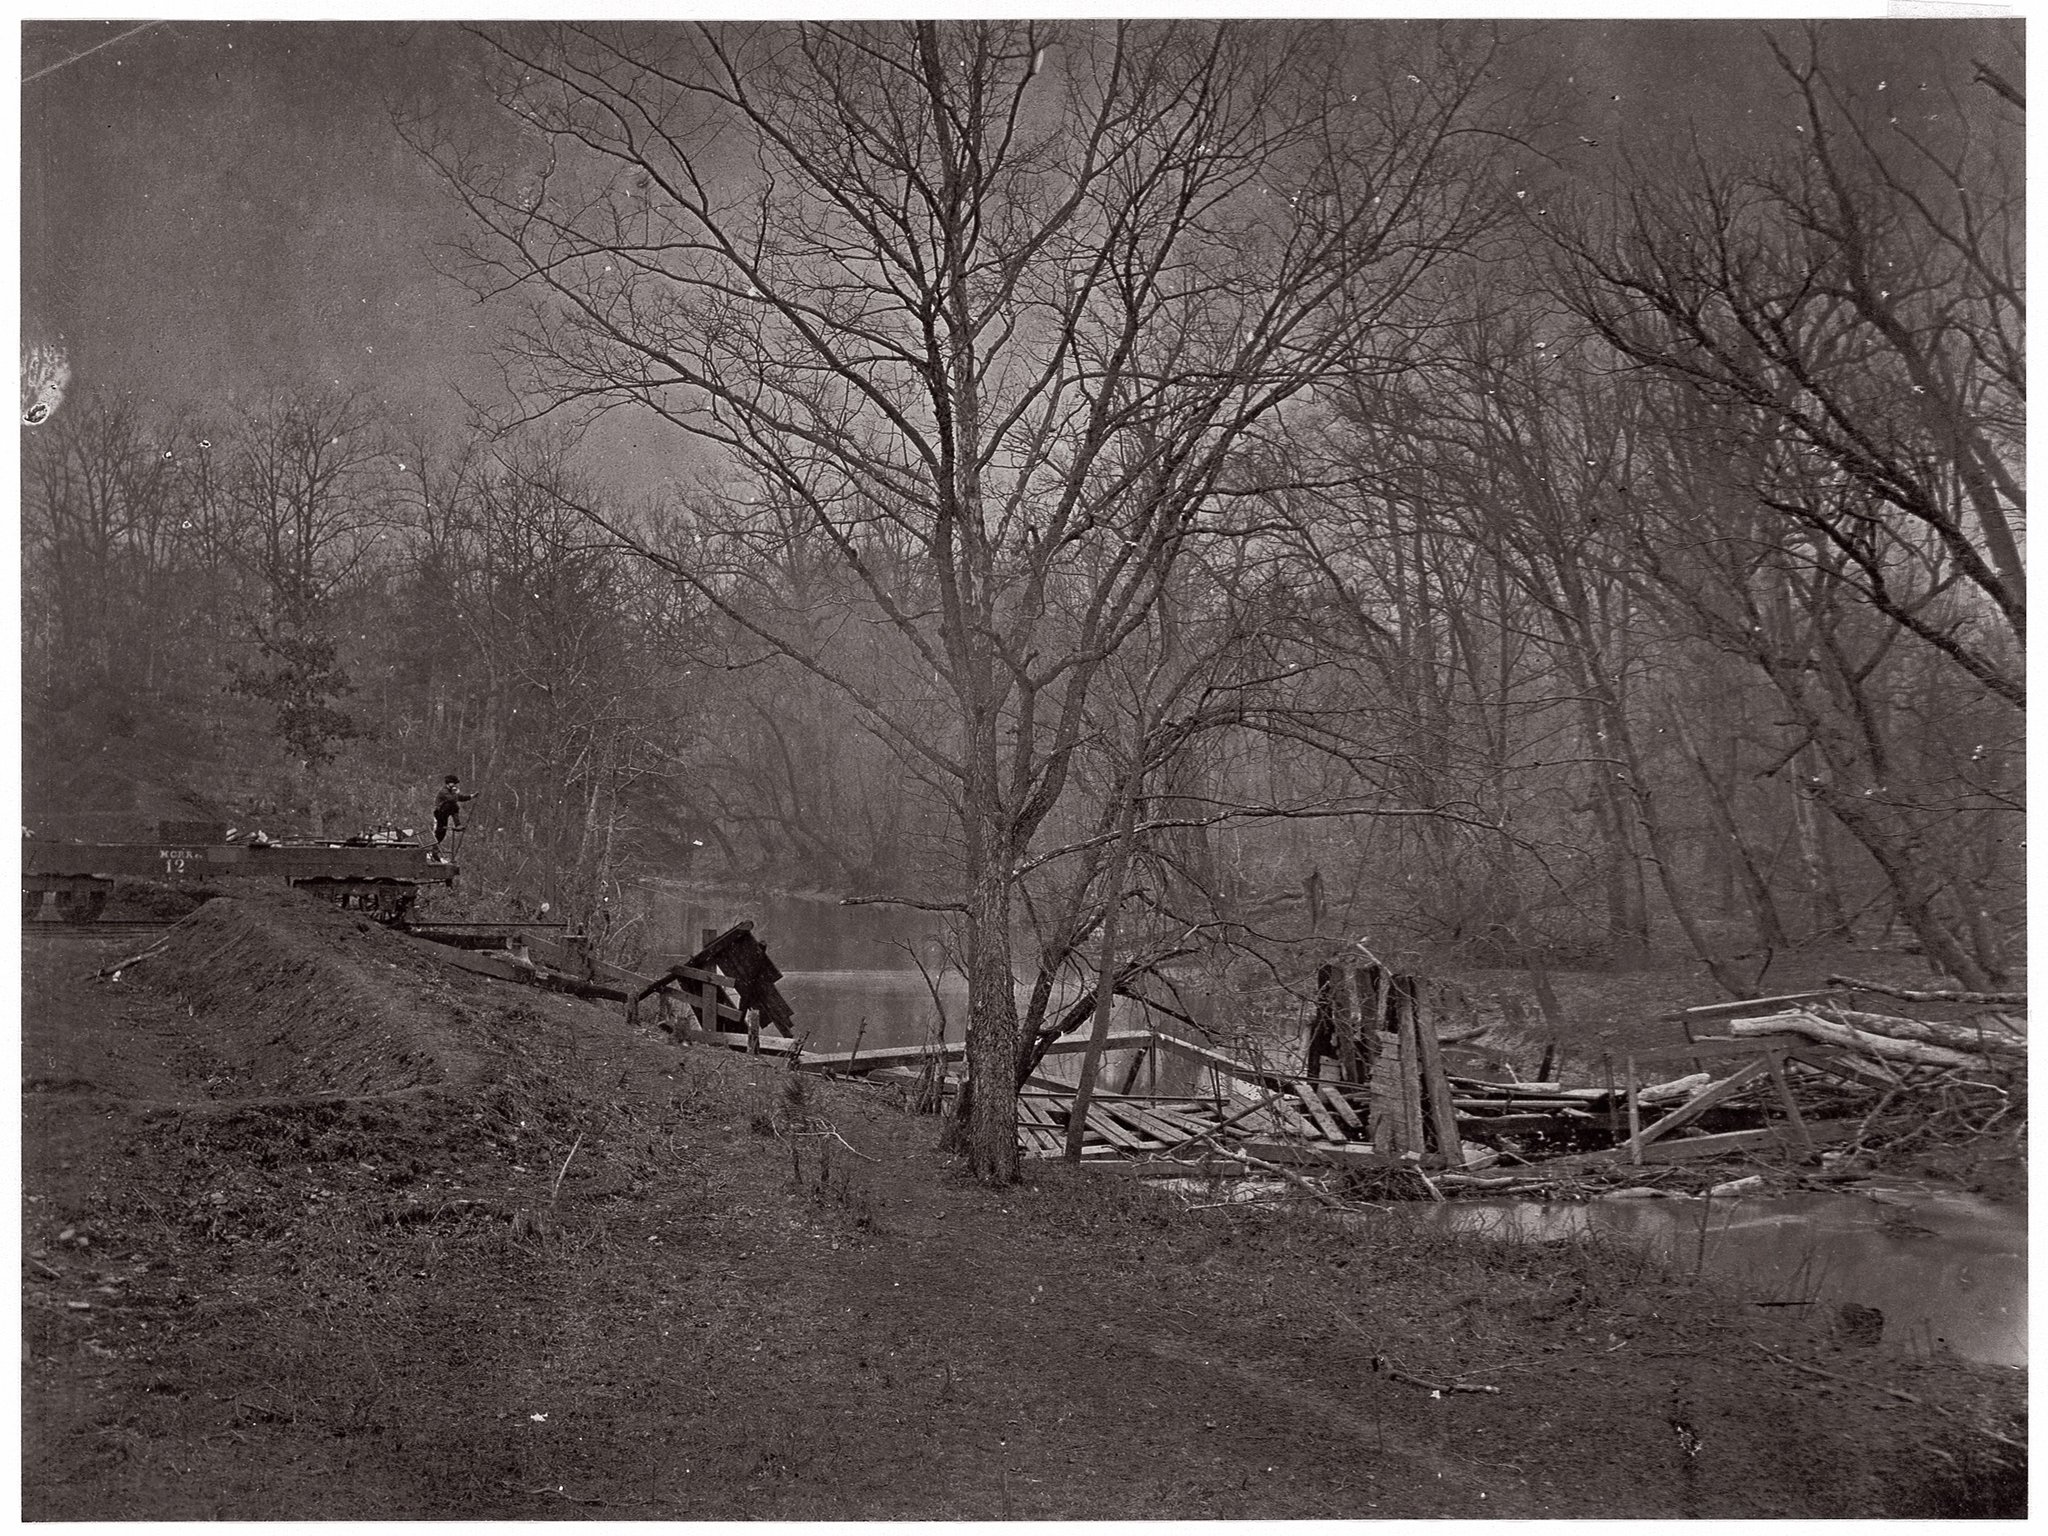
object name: photograph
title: Ruins of RR Bridge. Bull Run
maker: Anonymous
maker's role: artist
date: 1862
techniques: albumen silver print, glass negative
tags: american civil war,landscapes